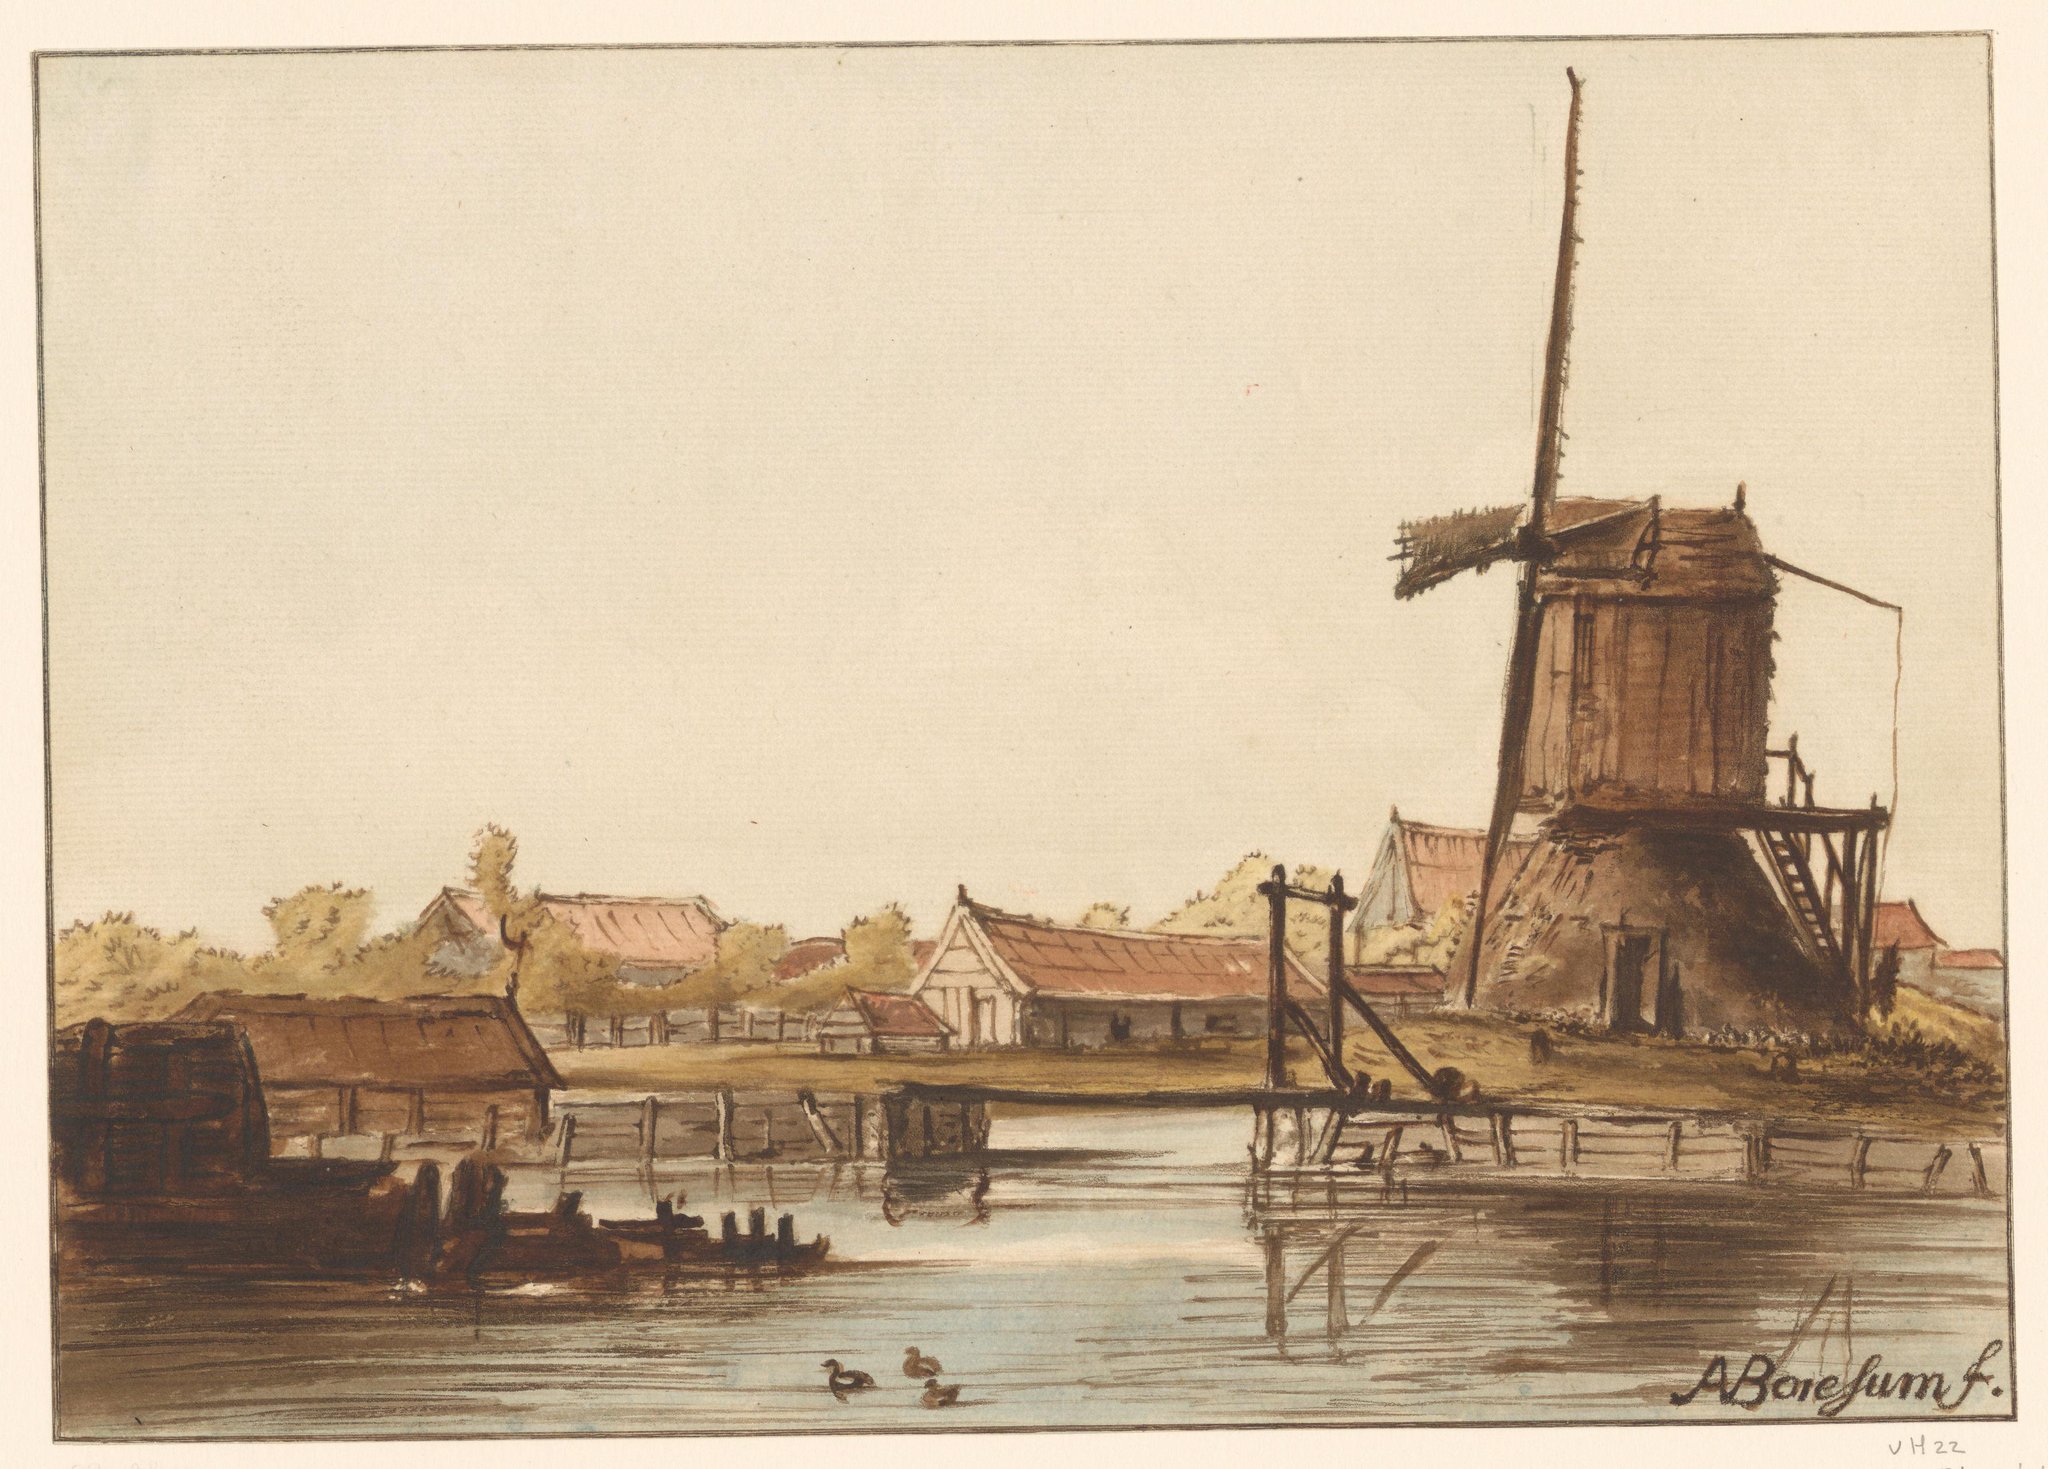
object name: print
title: Landschap met molen en huizen aan het water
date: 1818-1828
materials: paper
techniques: hand coloring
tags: windmill in landscape (+ city(-scape) with figures, staffage)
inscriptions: collector's mark: Lugt 12